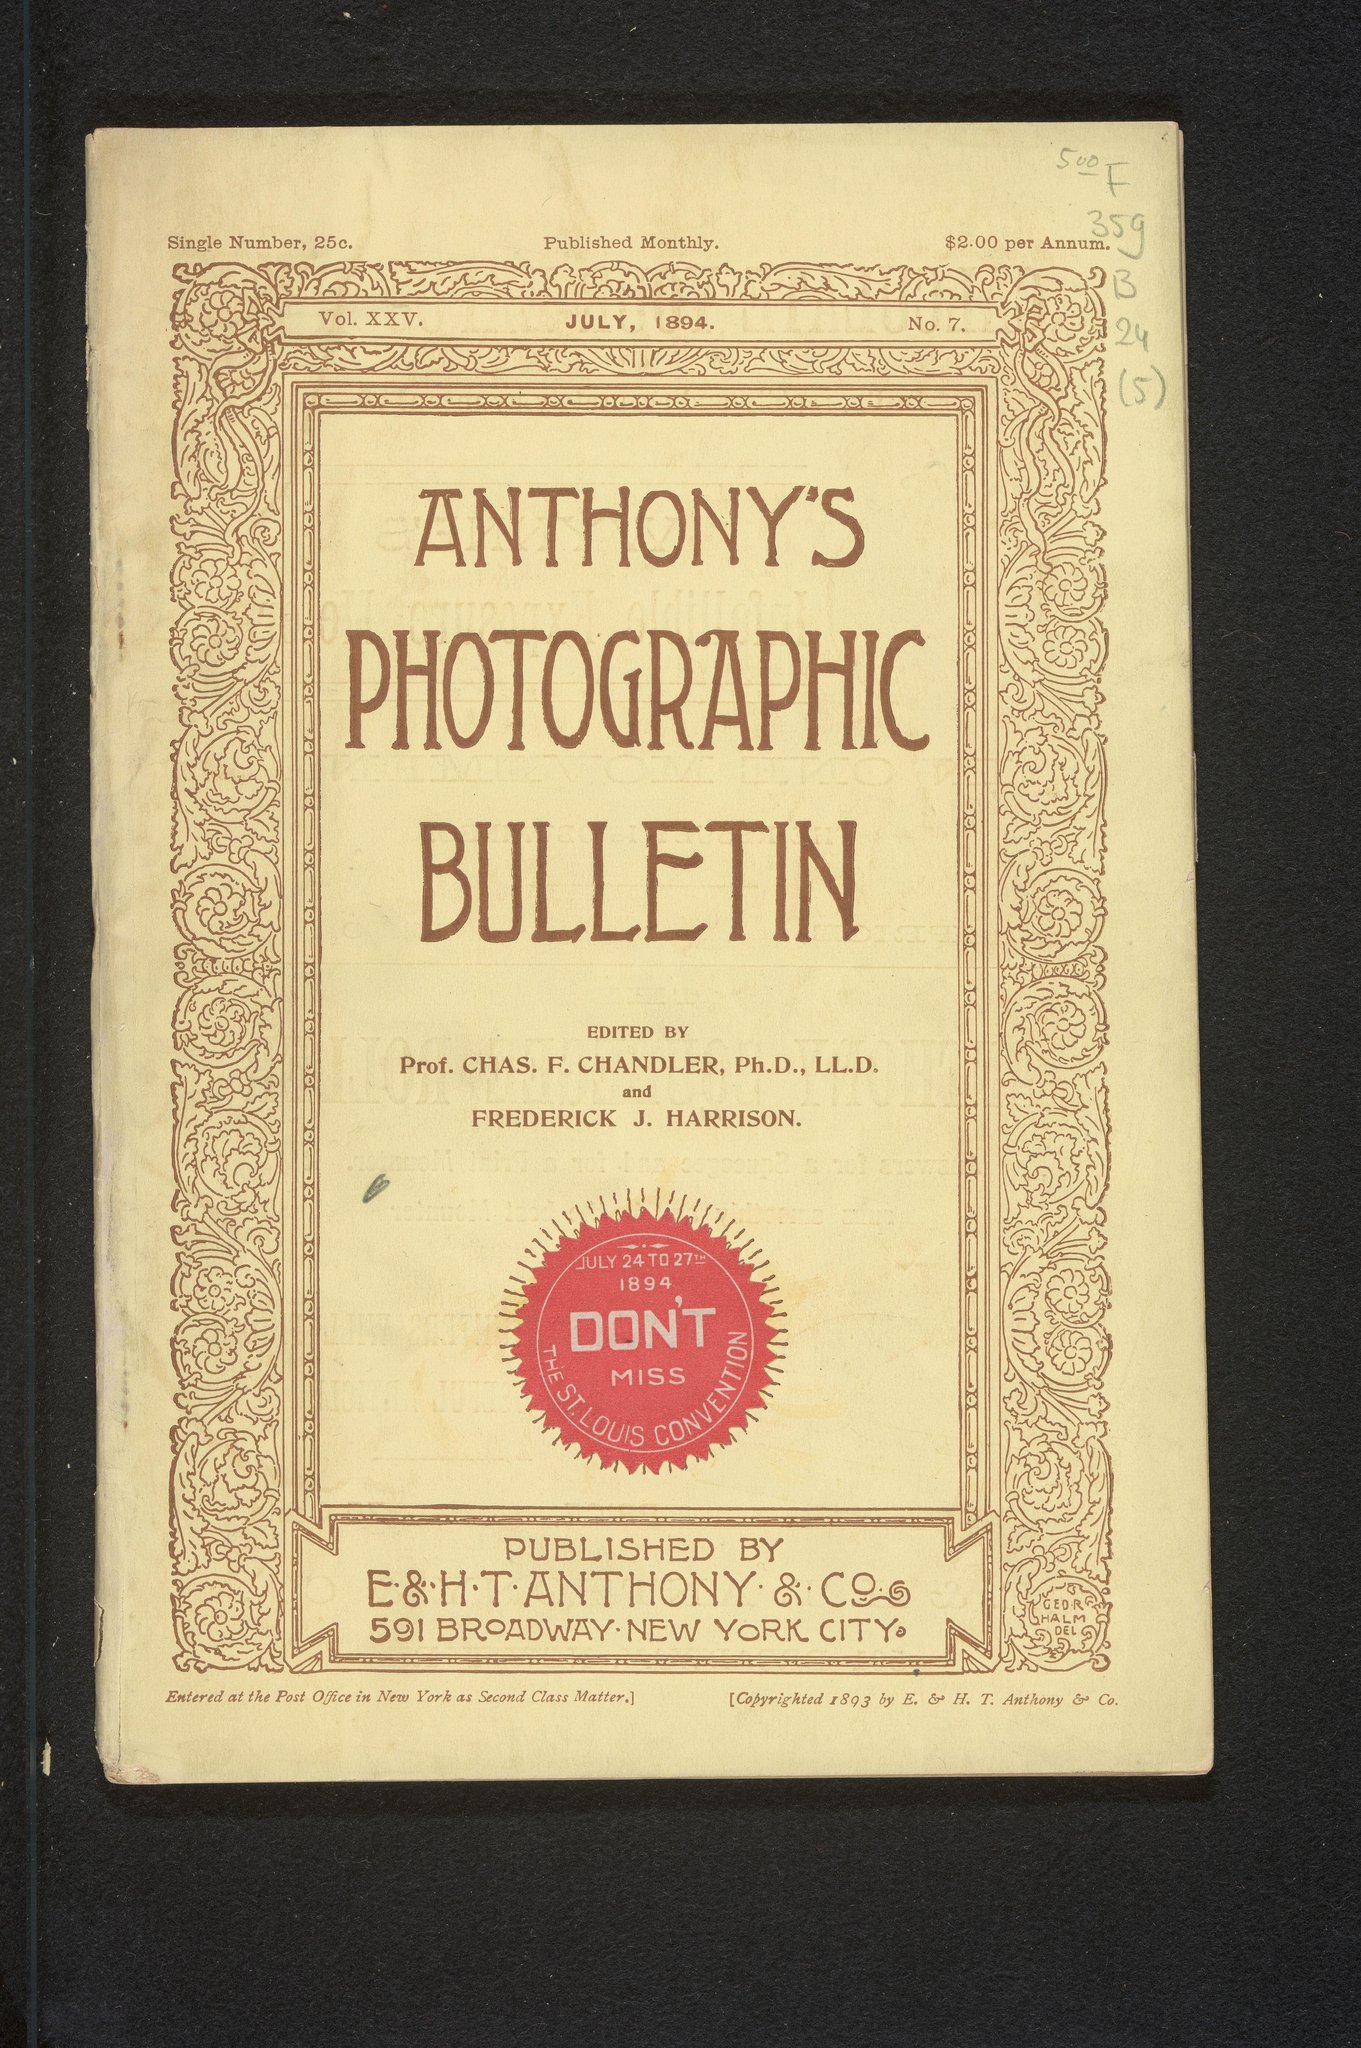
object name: book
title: Anthony's photographic bulletin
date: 1893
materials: paper, photographic support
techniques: printing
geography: new york city